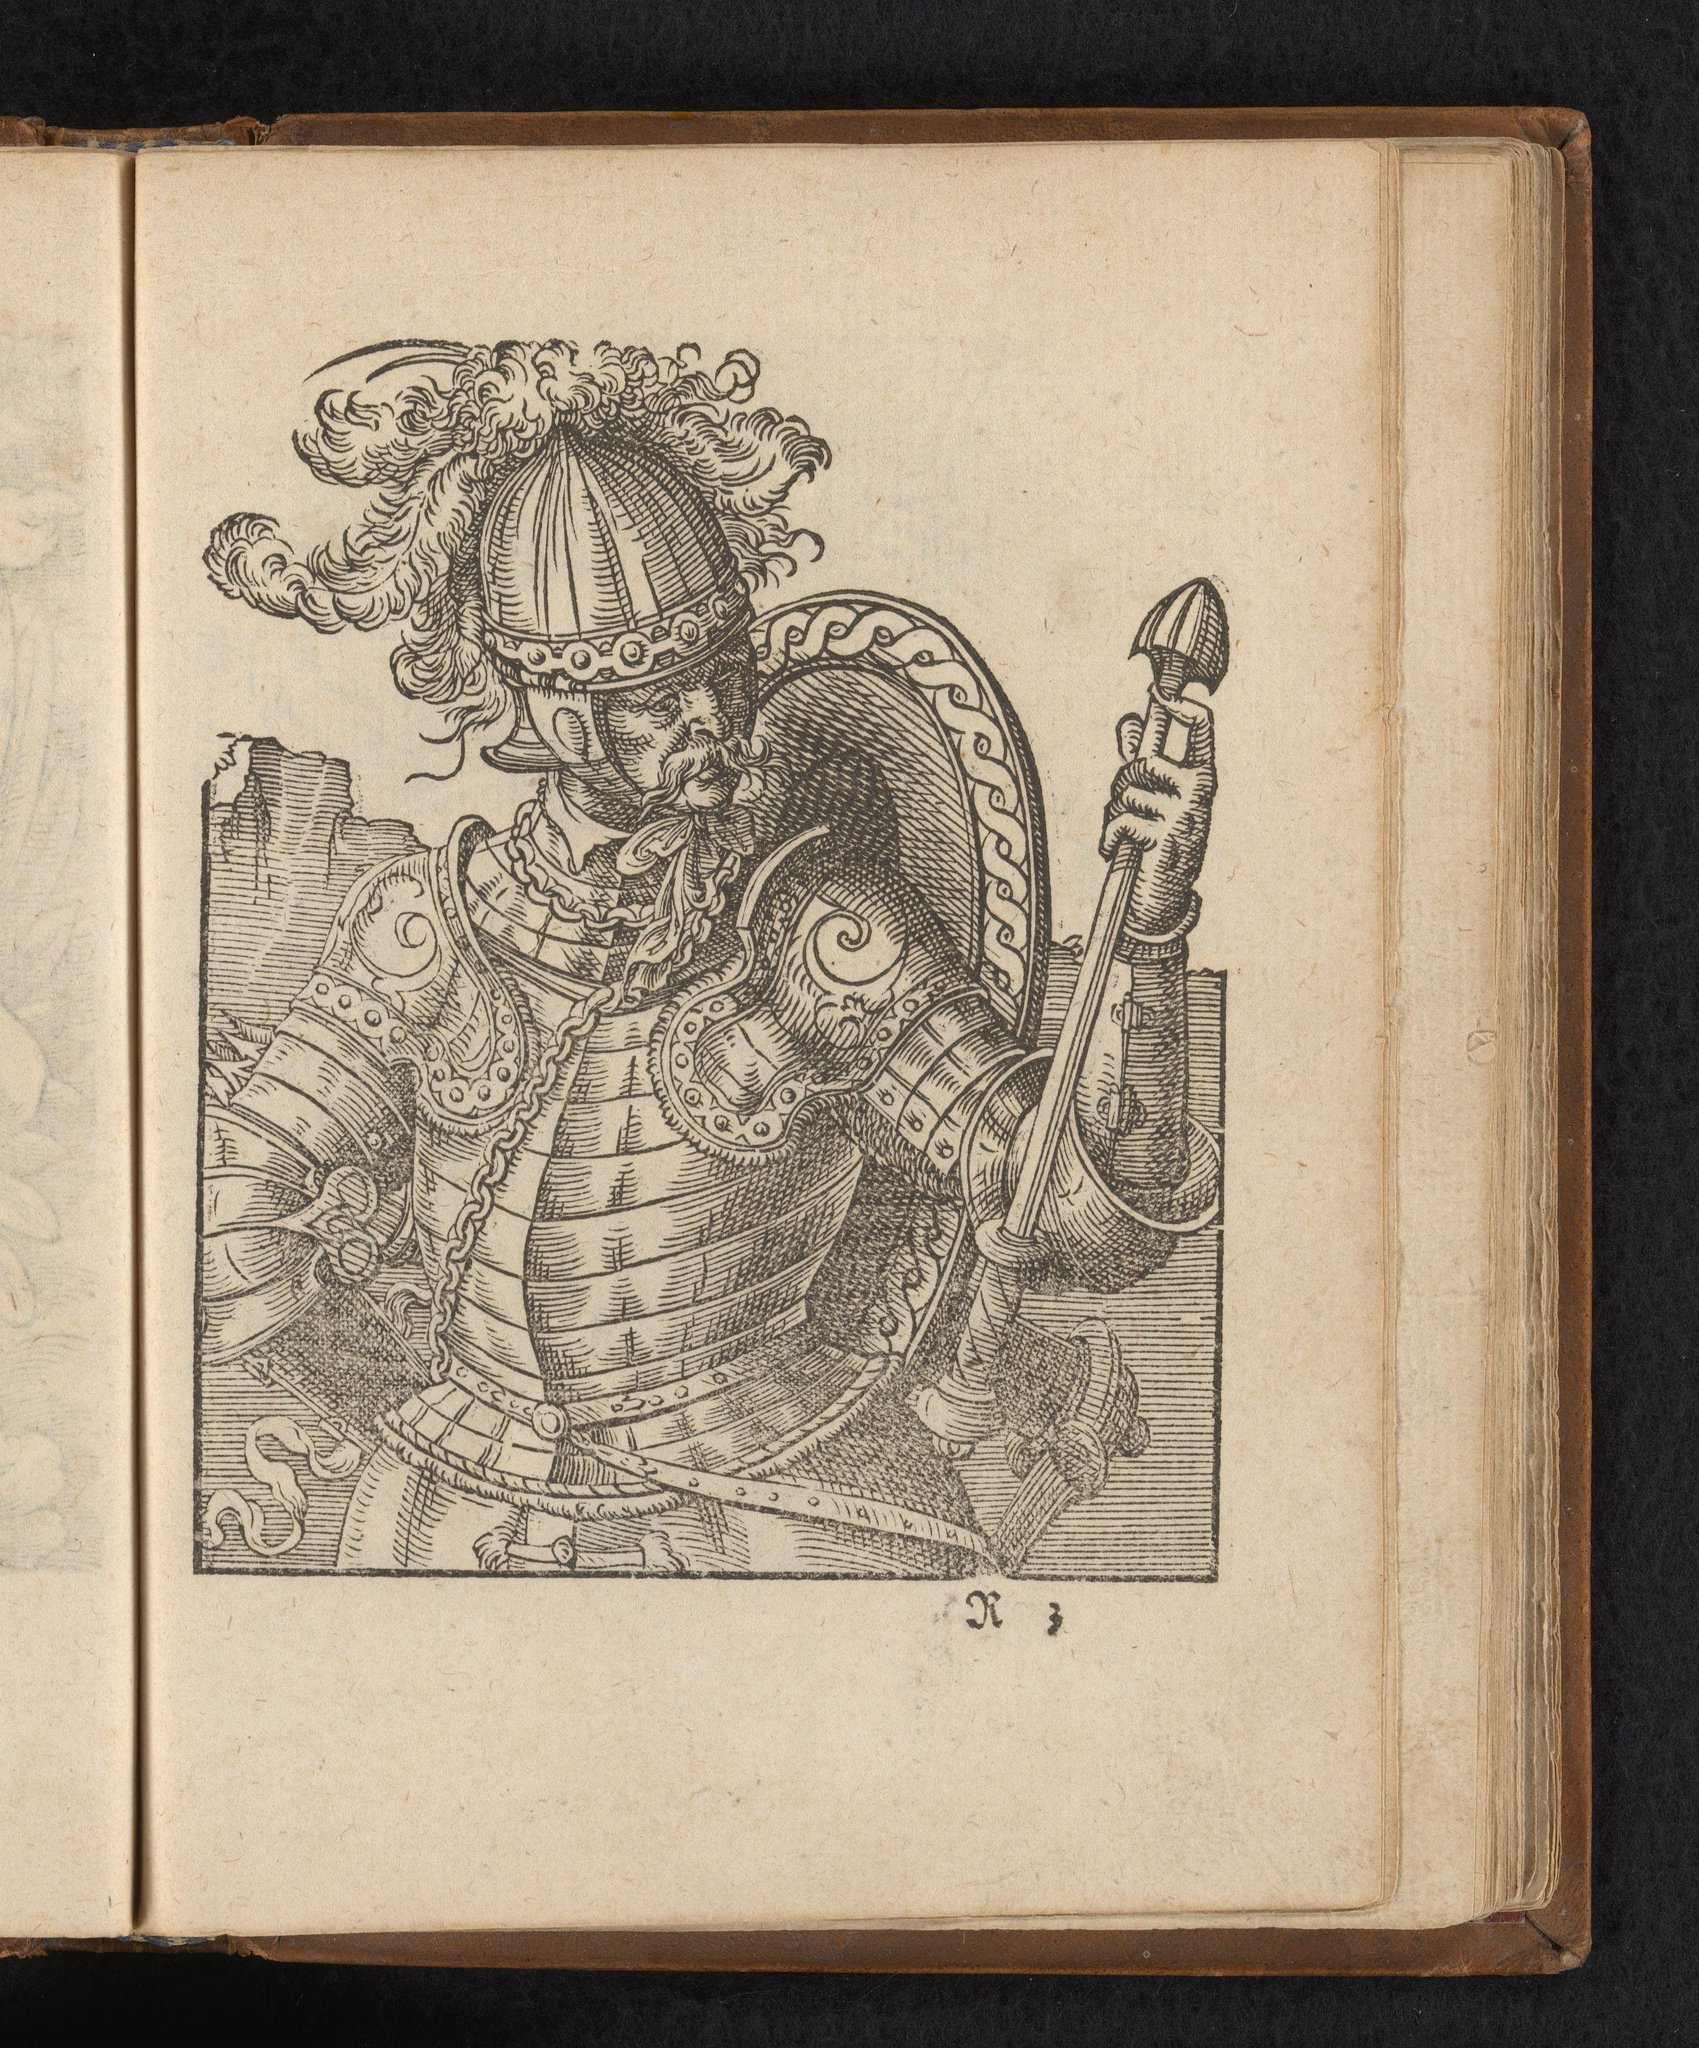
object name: print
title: Krijger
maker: Anonymous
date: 1578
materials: paper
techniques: woodcut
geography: nuremberg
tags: armour, land forces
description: Krijger in harnas, met een slagwapen of scepter in de hand, schild op de rug. Onderdeel van het modelboek Enchiridion artis pingendi, fingendi & sculpendi met 108 figuren bedoeld voor beginnende schilders, beeldhouwers en prentmakers.